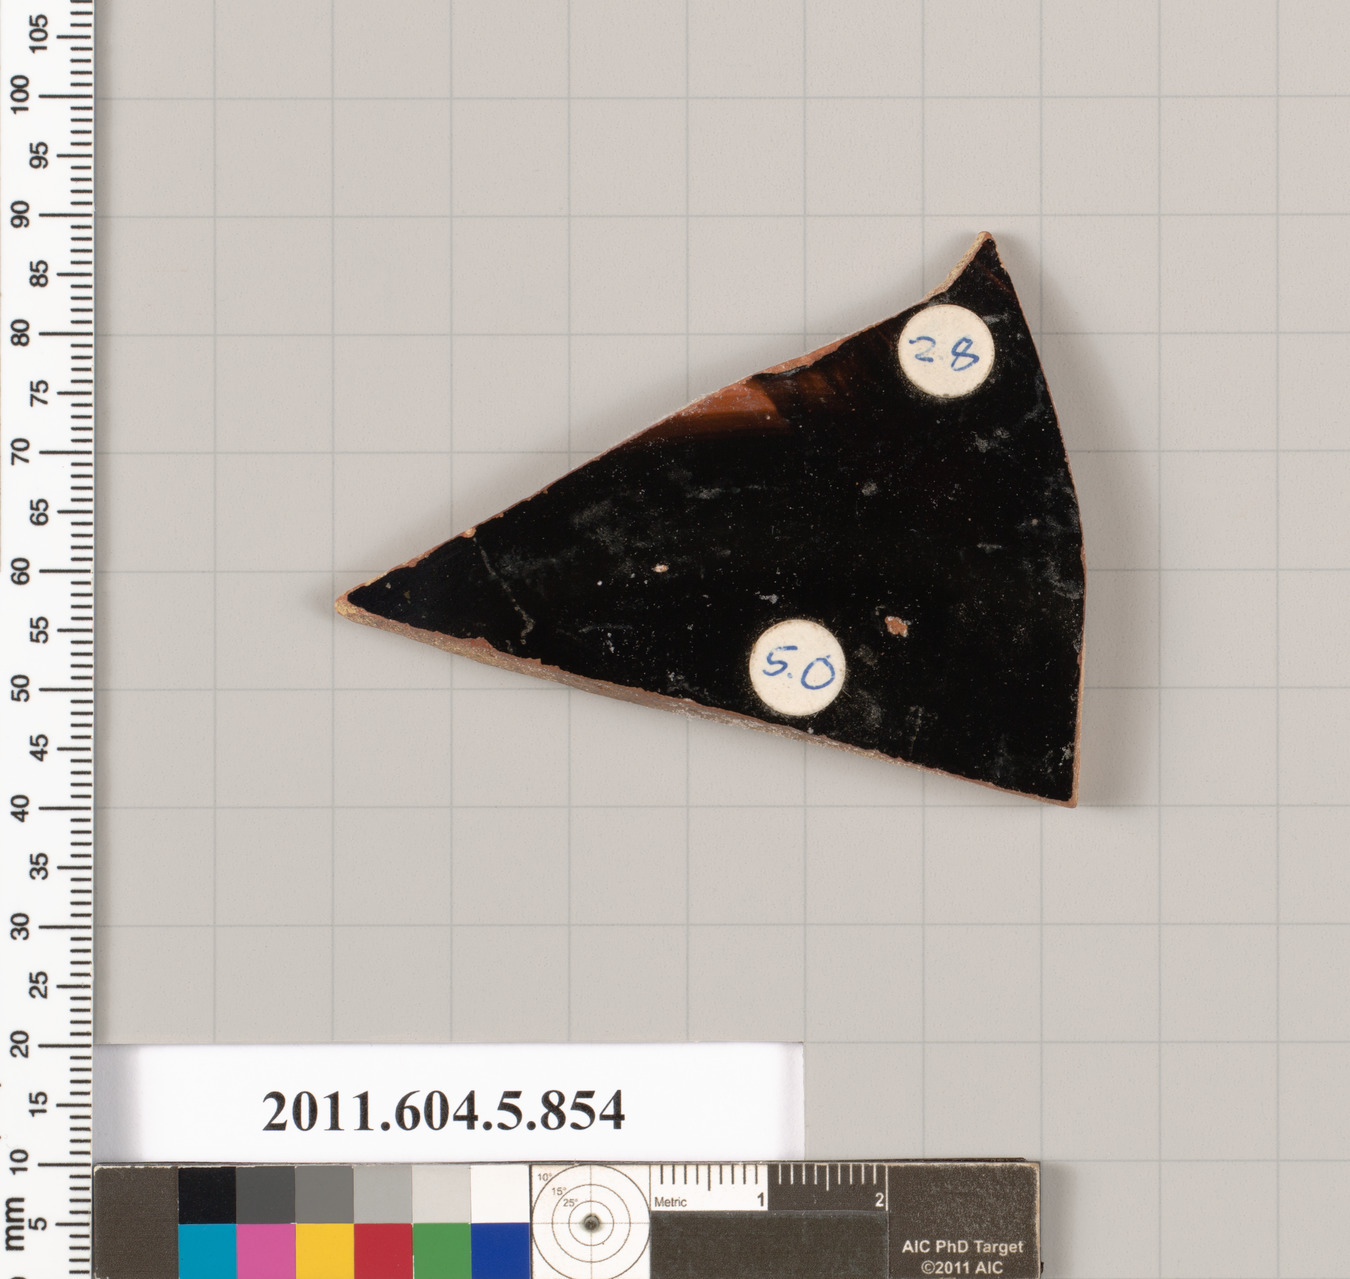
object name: kylix fragment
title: Terracotta fragment of a kylix (drinking cup)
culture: greek, attic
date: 600-401 BCE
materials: terracotta